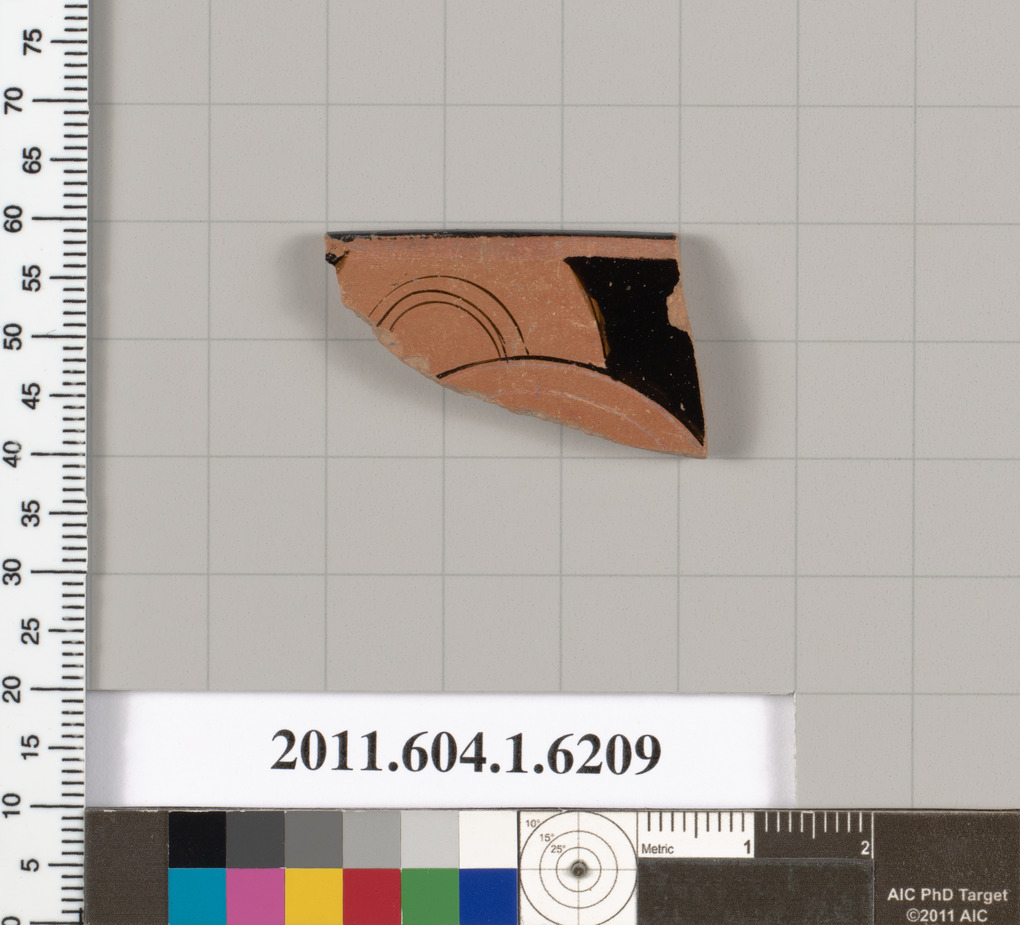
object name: kylix fragment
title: Terracotta rim fragment of a kylix (drinking cup)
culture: greek, attic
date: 510-500 BCE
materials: terracotta